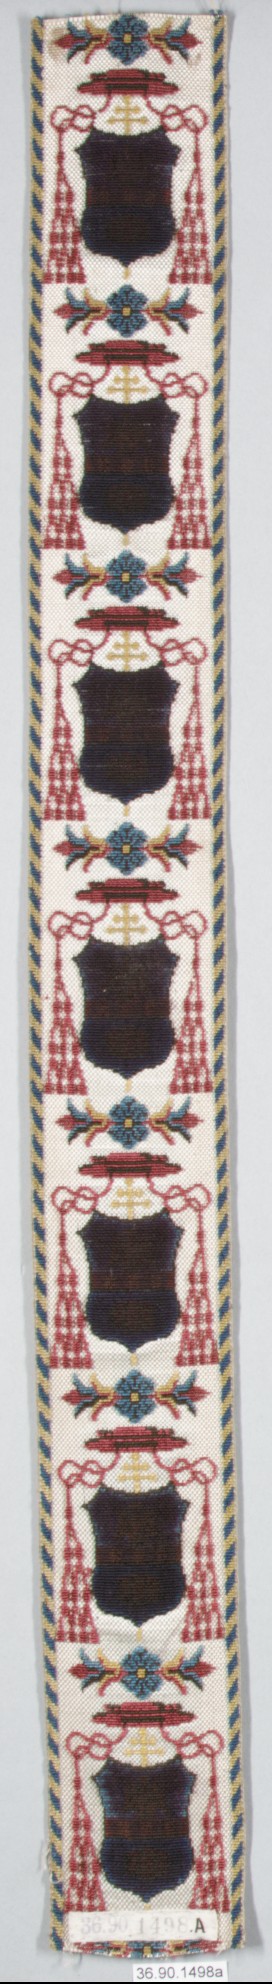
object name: galloon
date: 1701-1900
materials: silk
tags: coat of arms